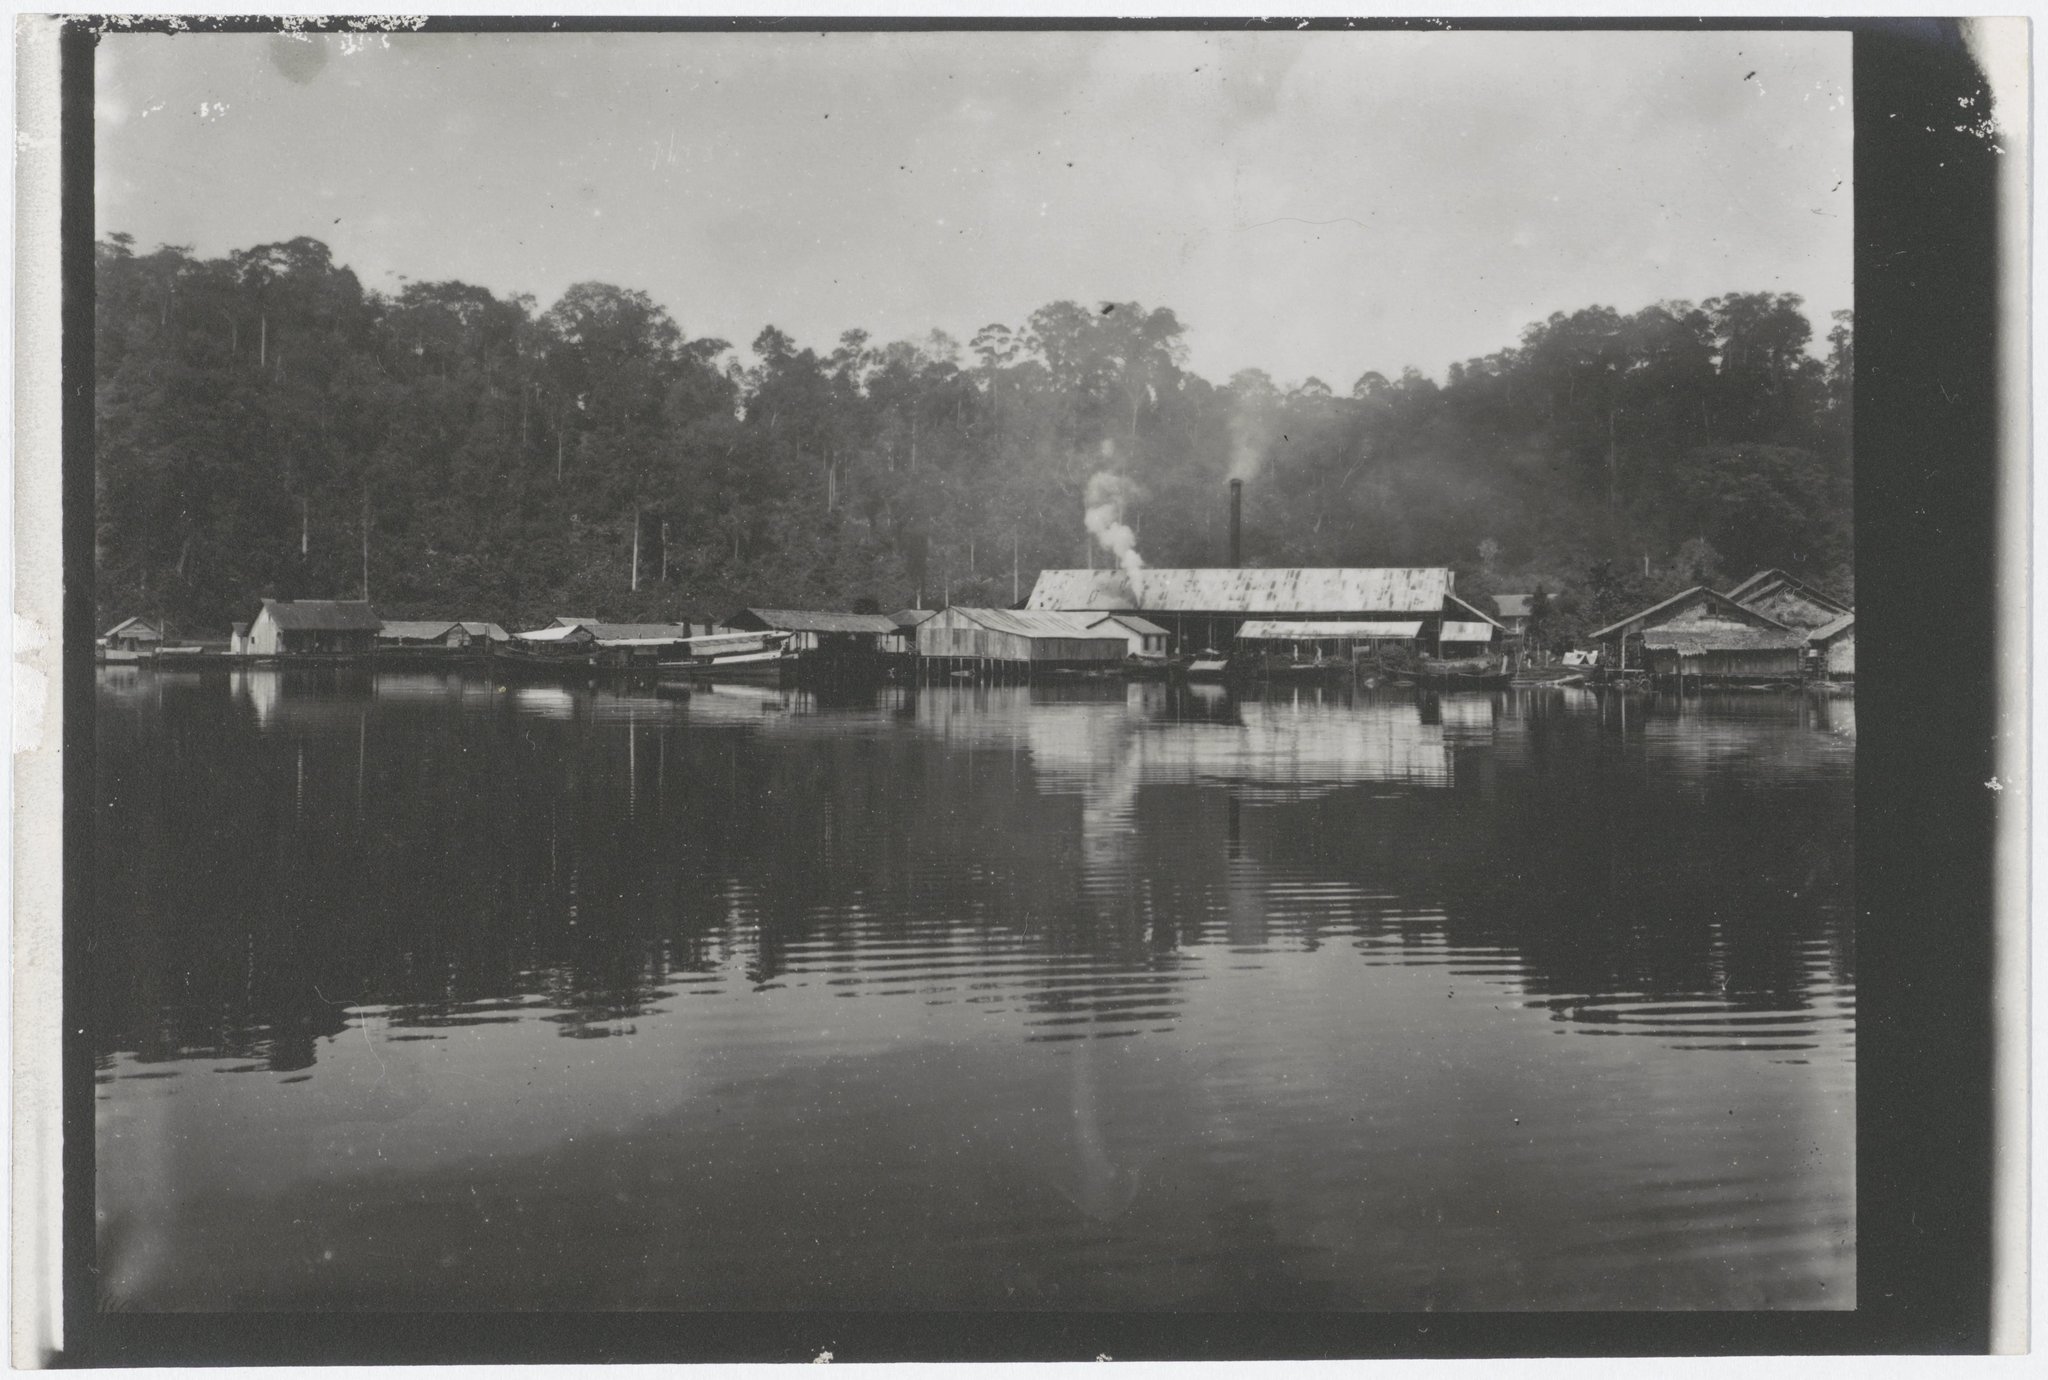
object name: photograph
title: Een fabriek in Telok, gelegen aan het water.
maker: johanna hermina marmelstein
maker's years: 1897-1990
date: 1900-1915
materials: paper, photographic support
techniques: albumen print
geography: jakarta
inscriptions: inscription: ‘Ingang van een aanzienlijk huis. Tempeltje, logis voor de huisgoden, stenen deurwachters.’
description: Een fabriek in Telok, gelegen aan het water. De fabriek heeft vele bijgebouwen en enkele aangemeerde boten.